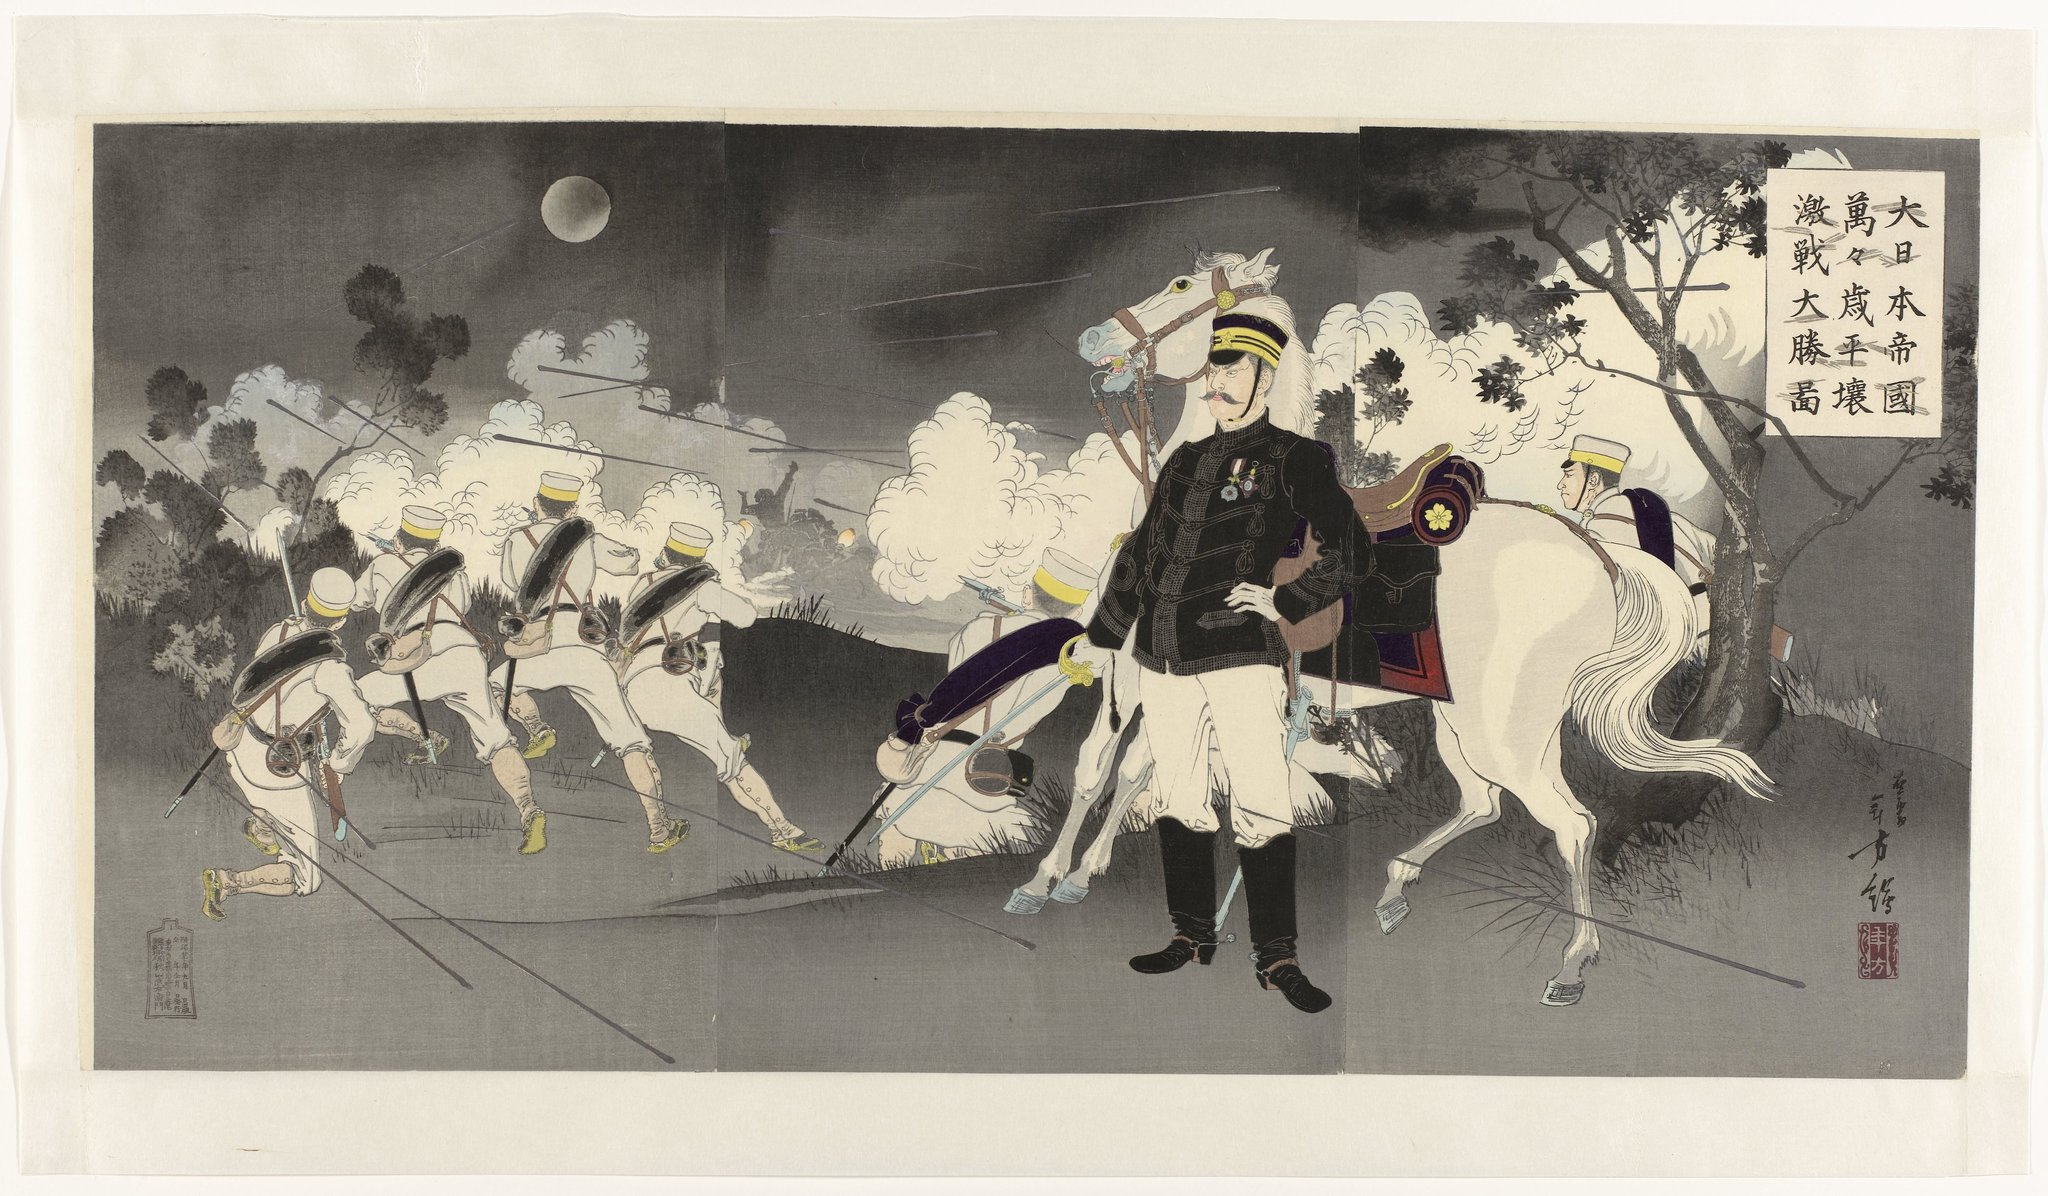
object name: print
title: Dai Nihon Teikoku ban banzai Heijô gekisen daishôri zu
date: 1894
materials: paper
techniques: woodcut, polish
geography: japan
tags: battle, firearms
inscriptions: label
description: Japans soldaten schieten op de Koreaanse en Chinese troepen van achter struikgewas. Een generaal op de voorgrond met zijn getrokken zwaard. Het gevecht om Pyongyang vond plaats in september 1894, de stad viel op de 16e van de maand tijdens de Eerste Chinees-Japanse Oorlog.